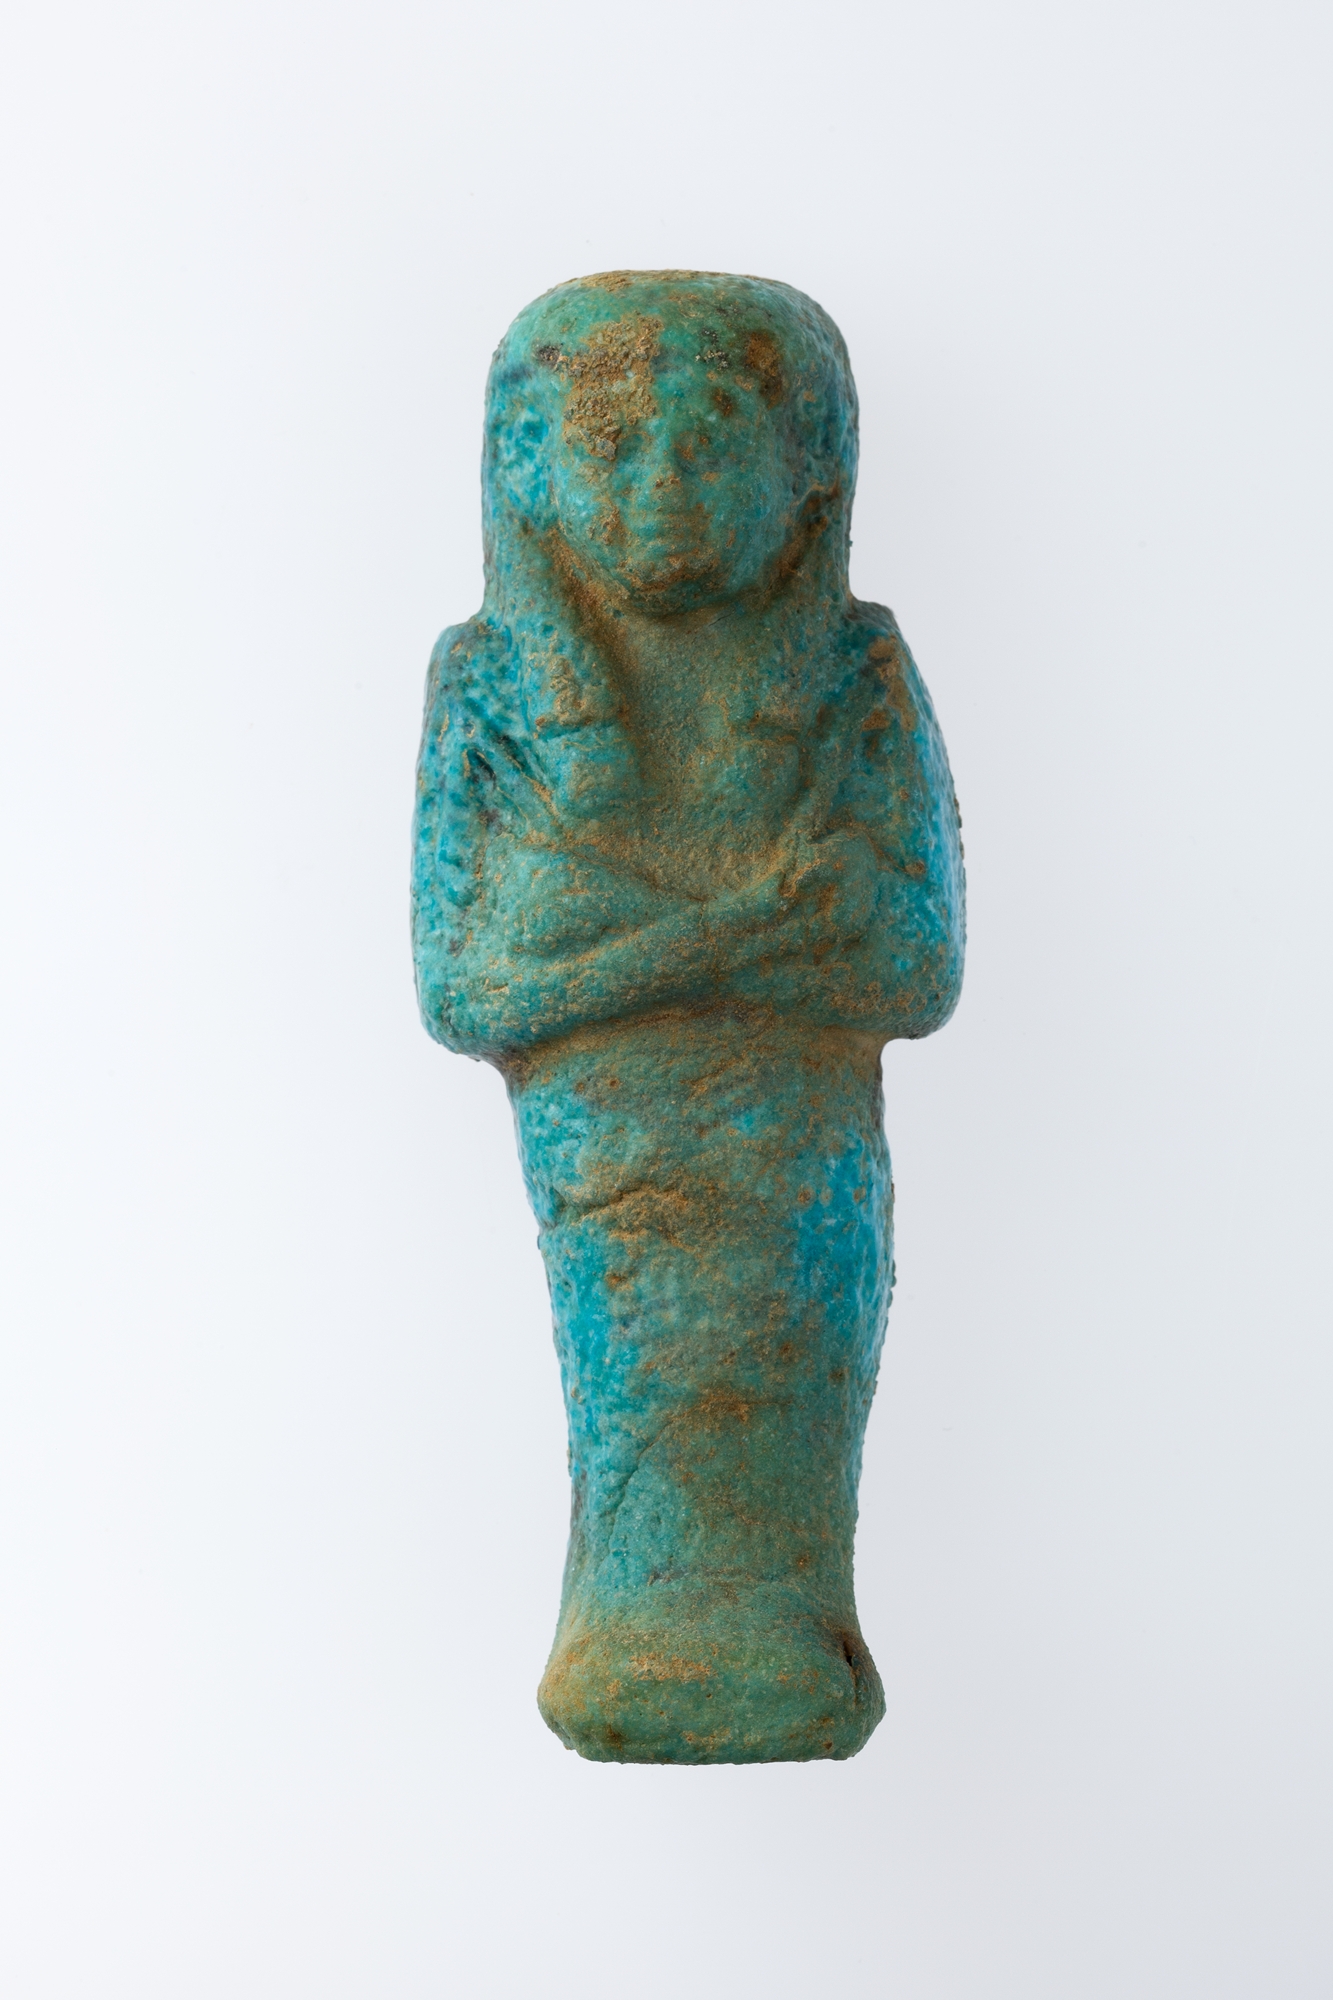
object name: shabti, henettawy c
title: Worker Shabti of Henettawy (C), Daughter of Isetemkheb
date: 990-970 BCE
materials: faience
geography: egypt